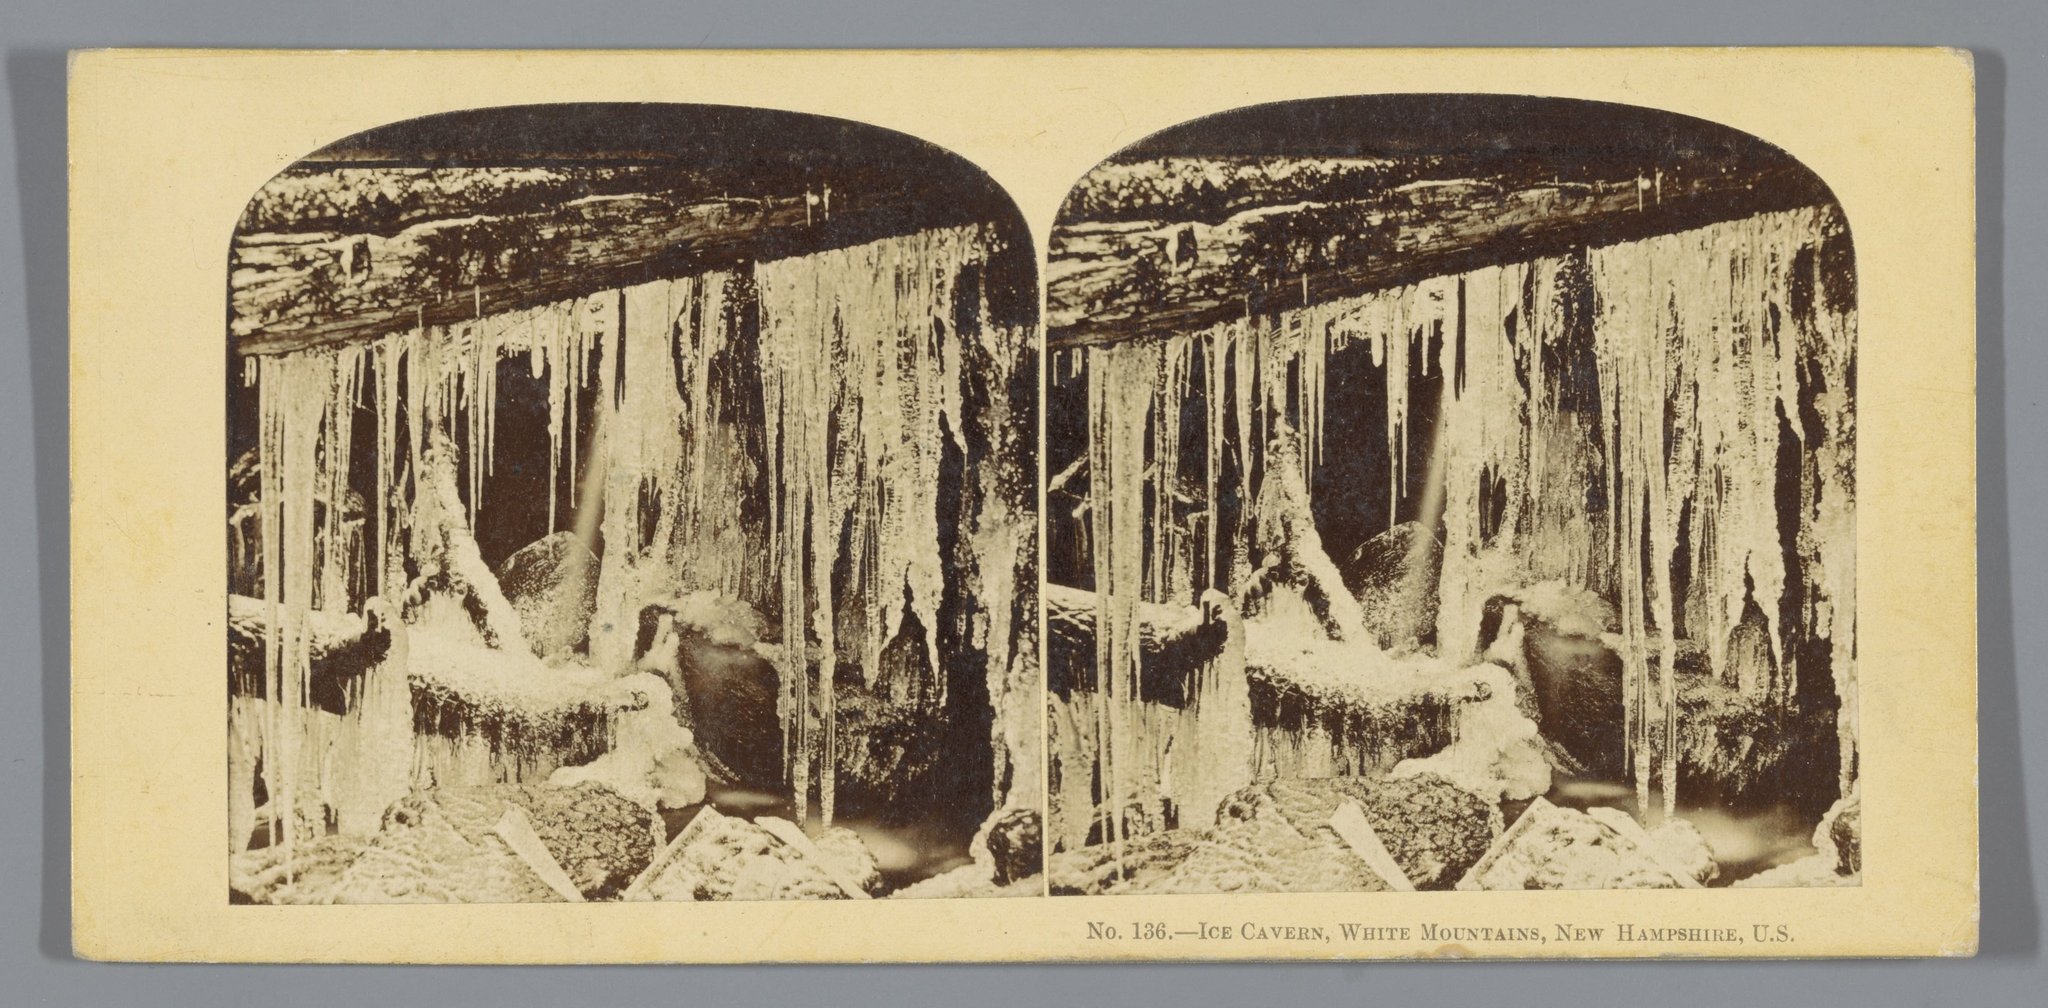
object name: stereograph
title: Ice Cavern, White Mountains, New Hampshire, U.S.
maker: william england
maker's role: fotograaf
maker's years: 1816-1896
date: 1859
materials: cardboard, paper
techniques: albumen print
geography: london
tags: stalactitic cave, icicle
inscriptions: number: ‘No. 136’, : ‘This group (...) therein." Bryant.’